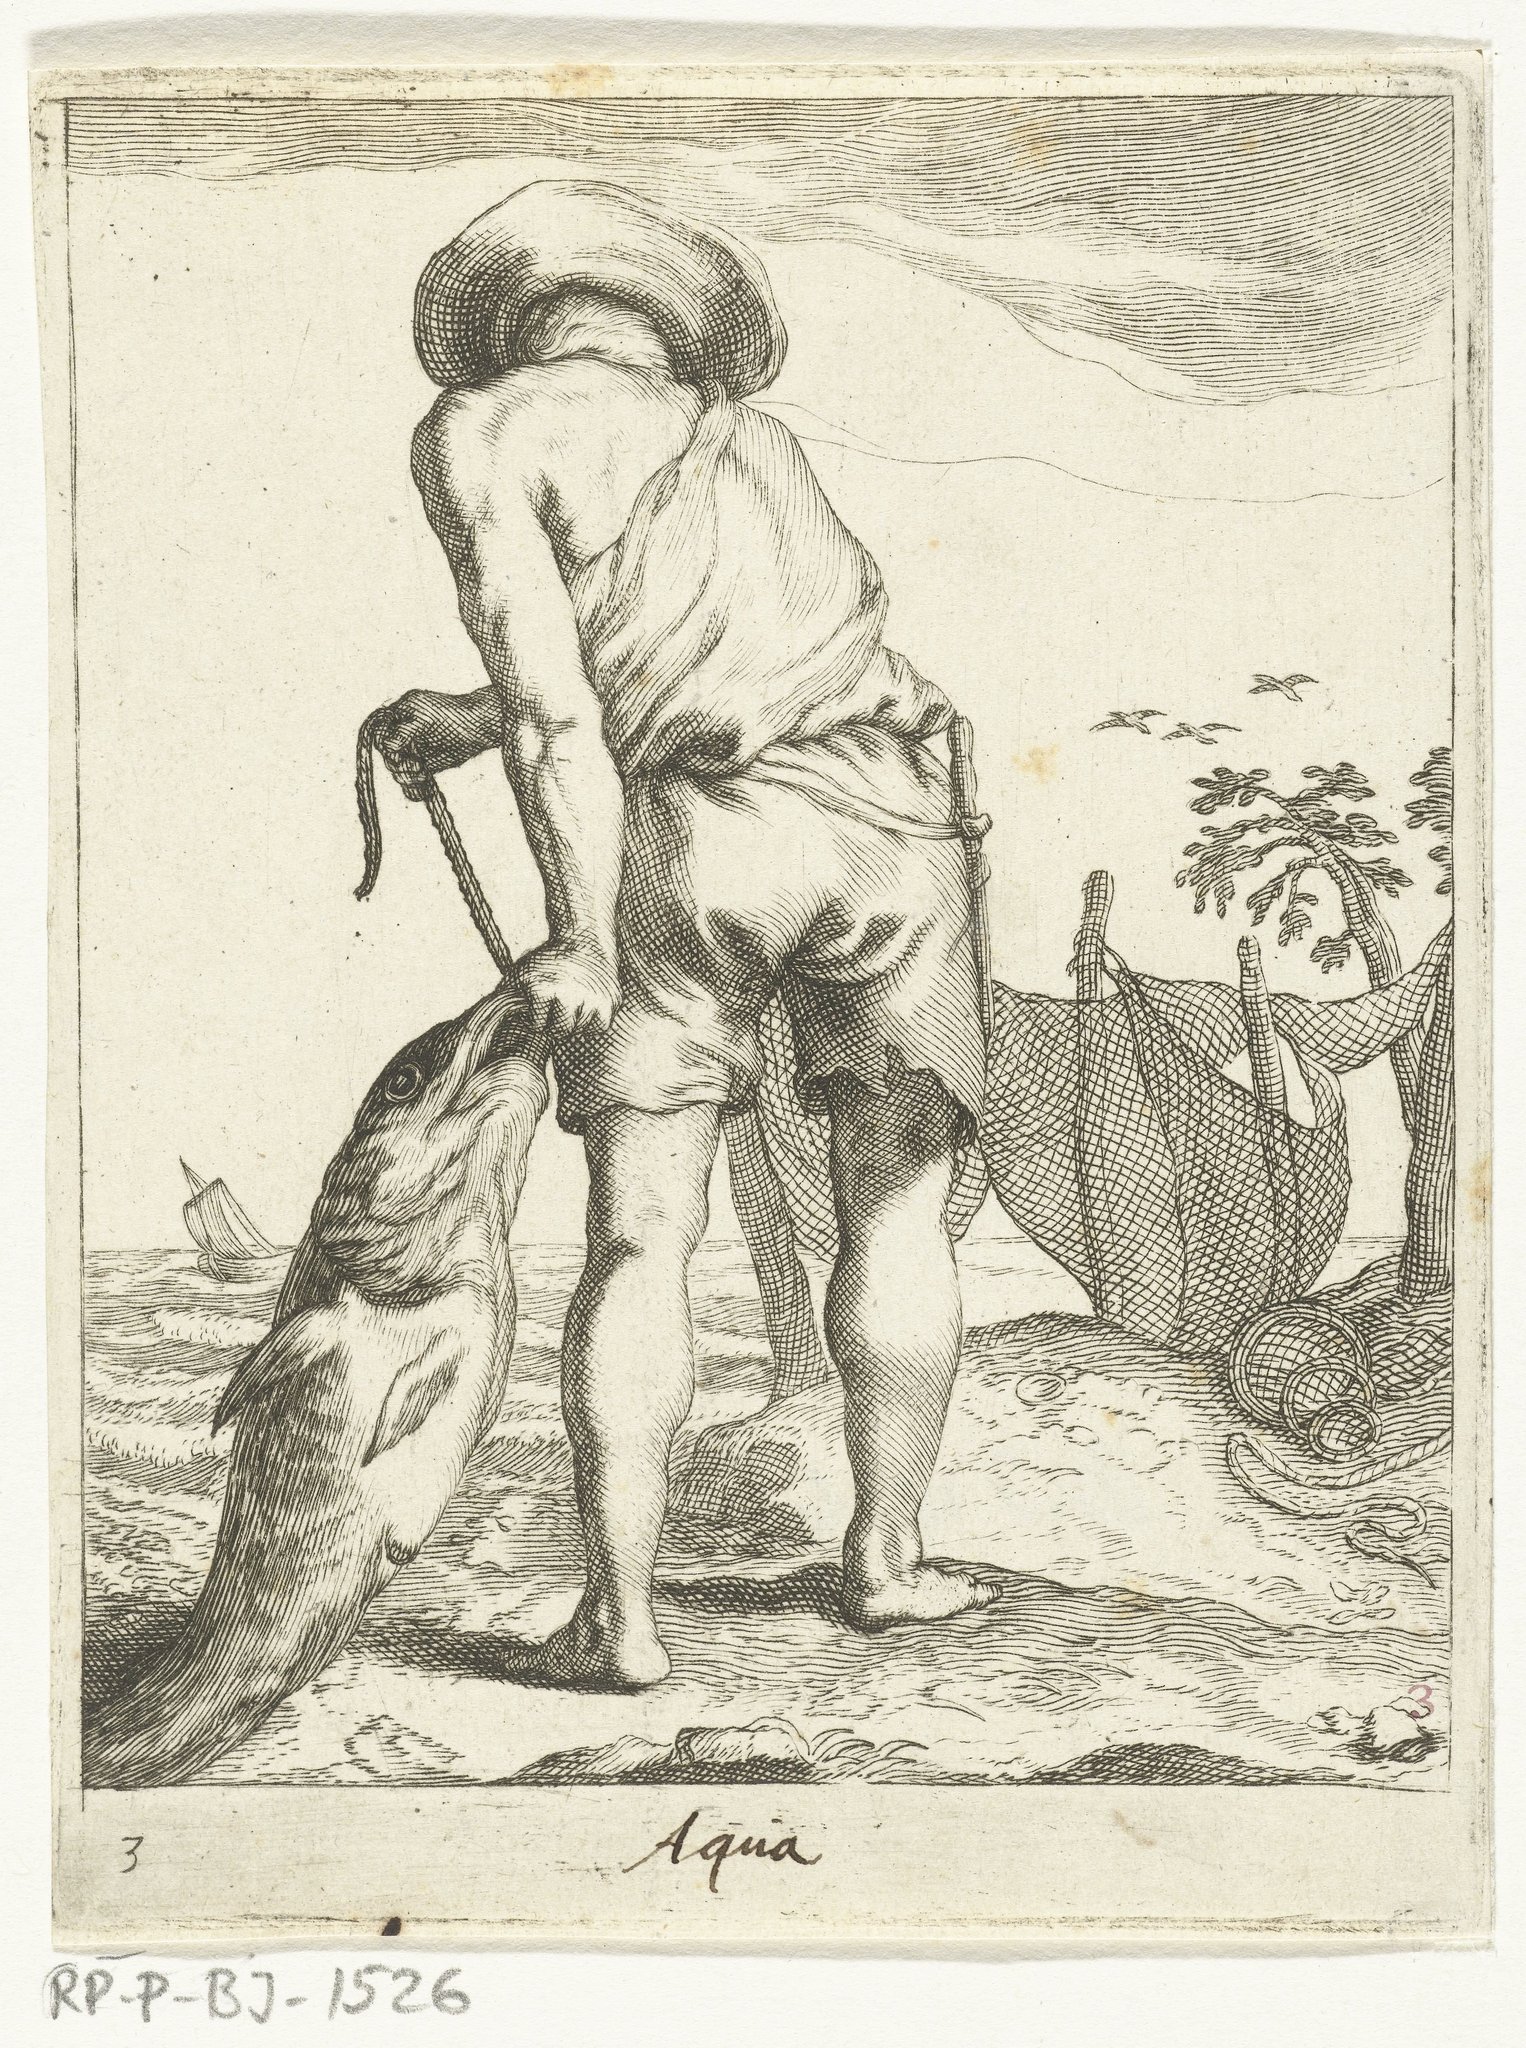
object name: print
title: De vier elementen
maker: frederick bloemaert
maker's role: print maker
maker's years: 1614-1669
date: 1632-1670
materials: paper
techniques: engraving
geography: utrecht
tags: water (one of the four elements), fisherman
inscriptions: number: ‘3’, inscription: ‘Aqua’, collector's mark: Lugt 240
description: Een visser trekt zijn vangst aan land. Op de achtergrond hangt een net te drogen.